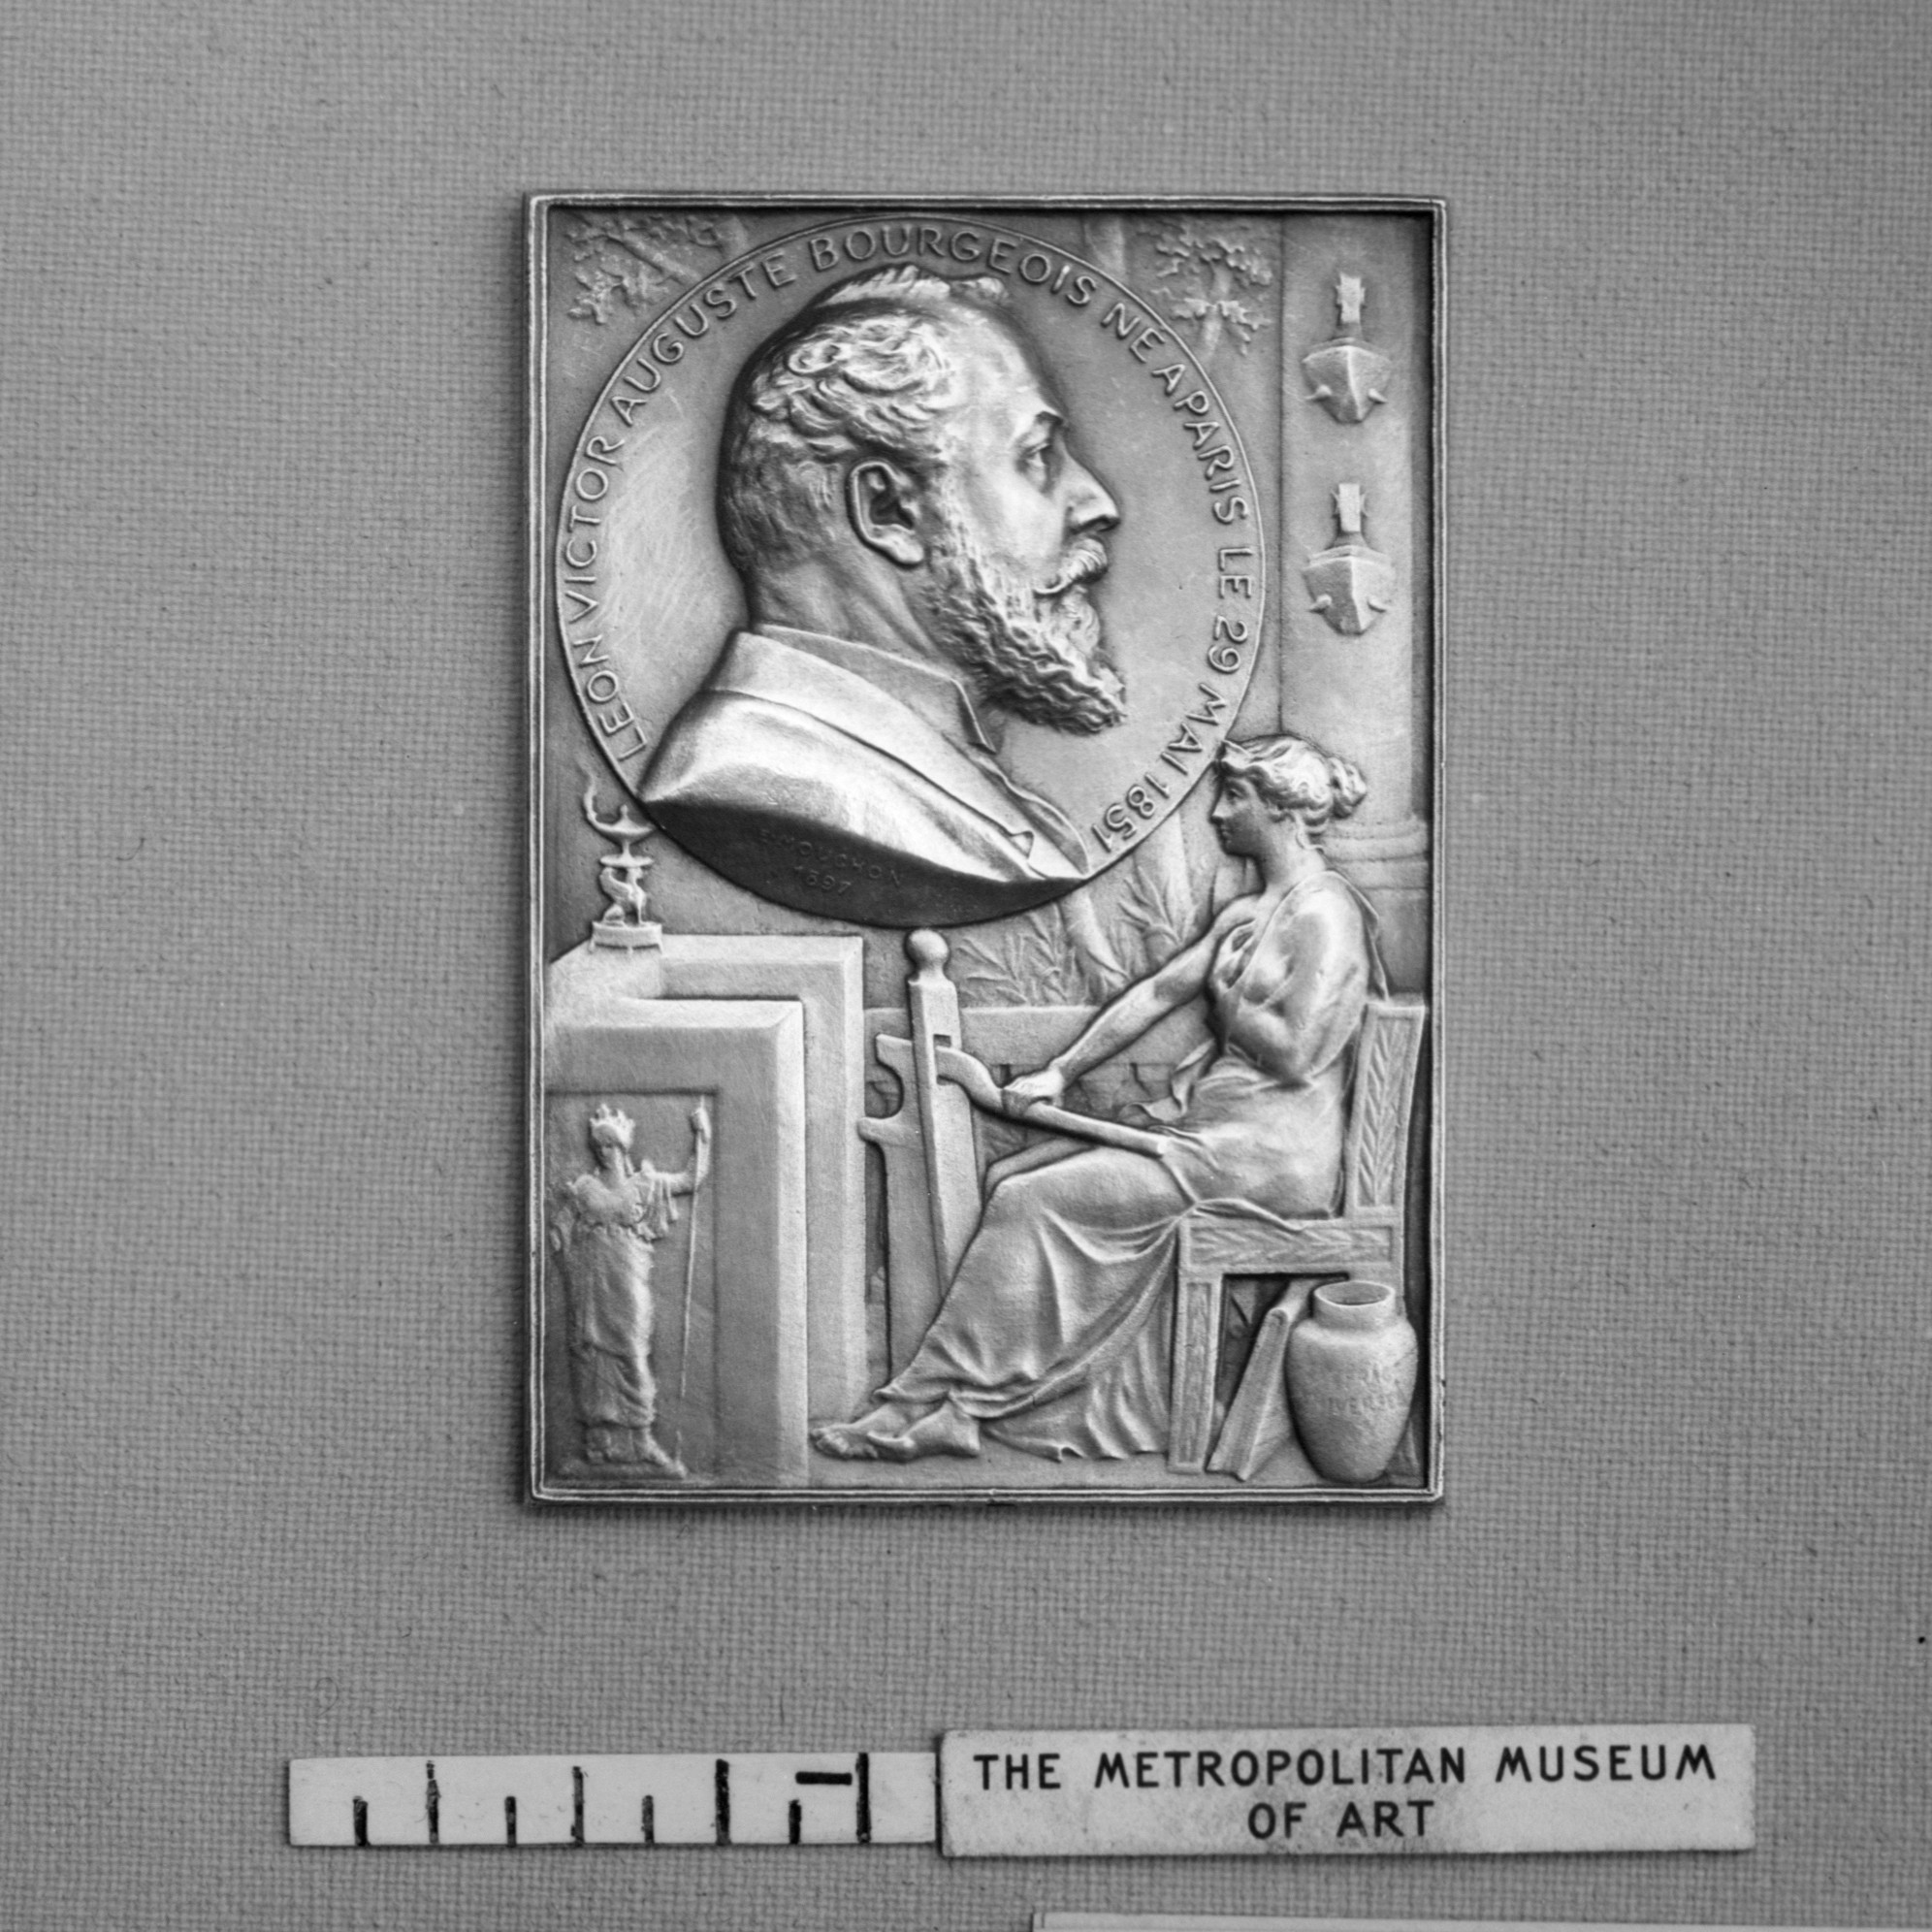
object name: plaquette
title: In Honor of M. Bourgeois, a French Radical Politician, Premier for a short time in 1896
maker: louis eugène mouchon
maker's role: artist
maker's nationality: french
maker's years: 1843-1914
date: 1897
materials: bronze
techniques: silvered, struck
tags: men,profiles,women